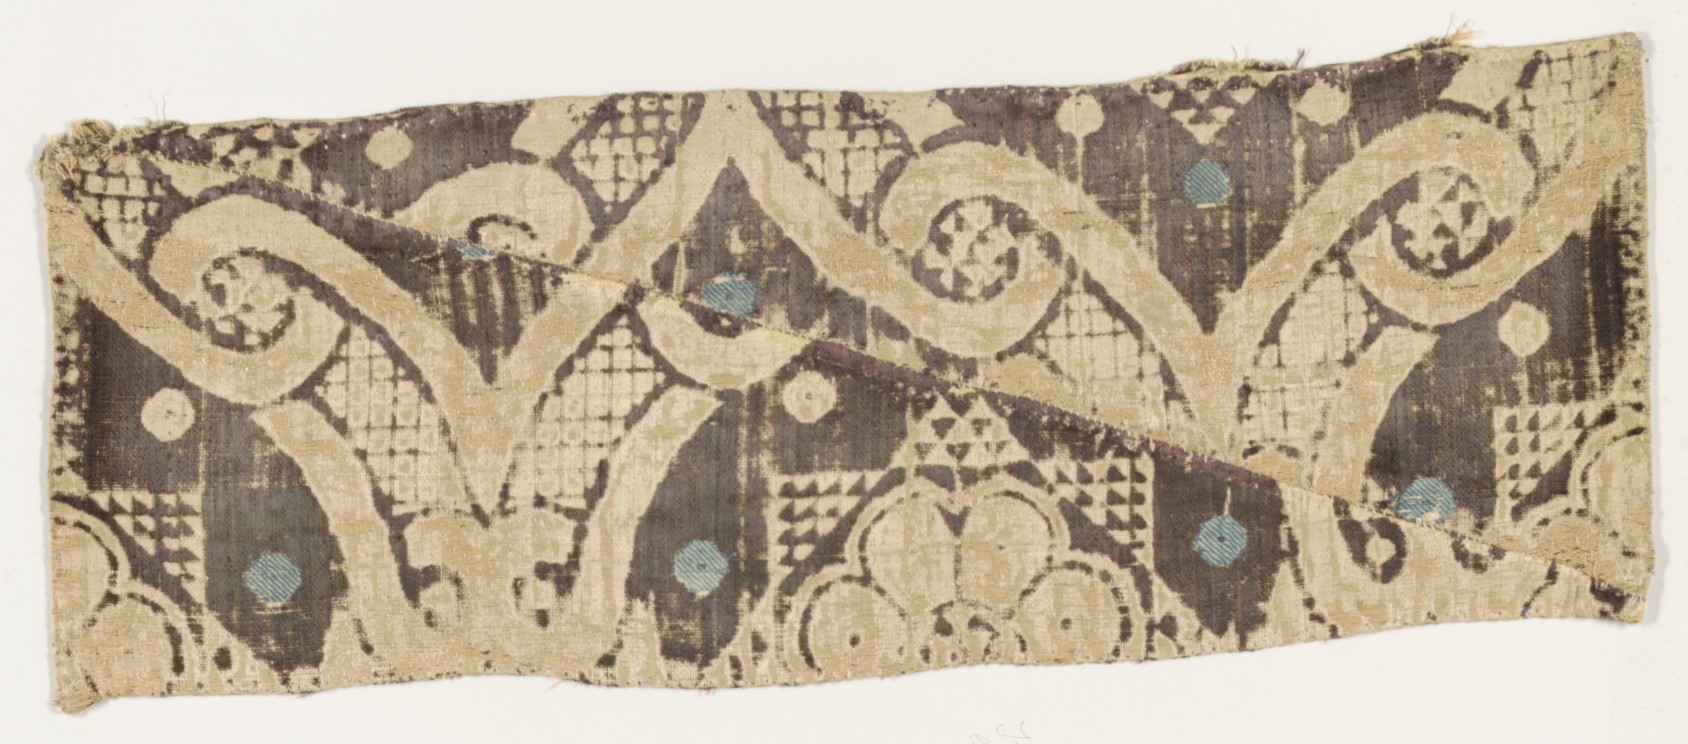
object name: fragment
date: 1401-1600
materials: silk